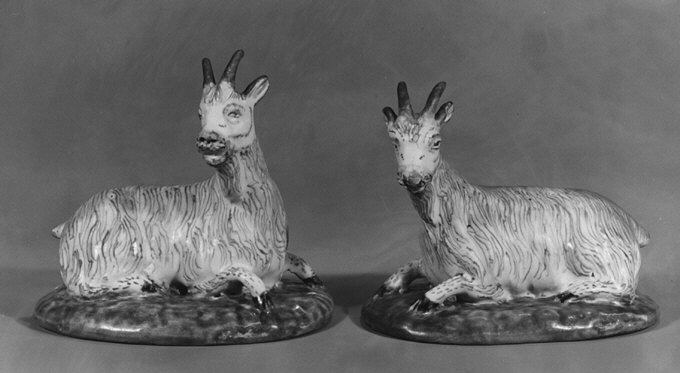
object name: figure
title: Pair of goats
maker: anthoni pennis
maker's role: maker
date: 1759-1782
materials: earthenware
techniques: glazing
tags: goats